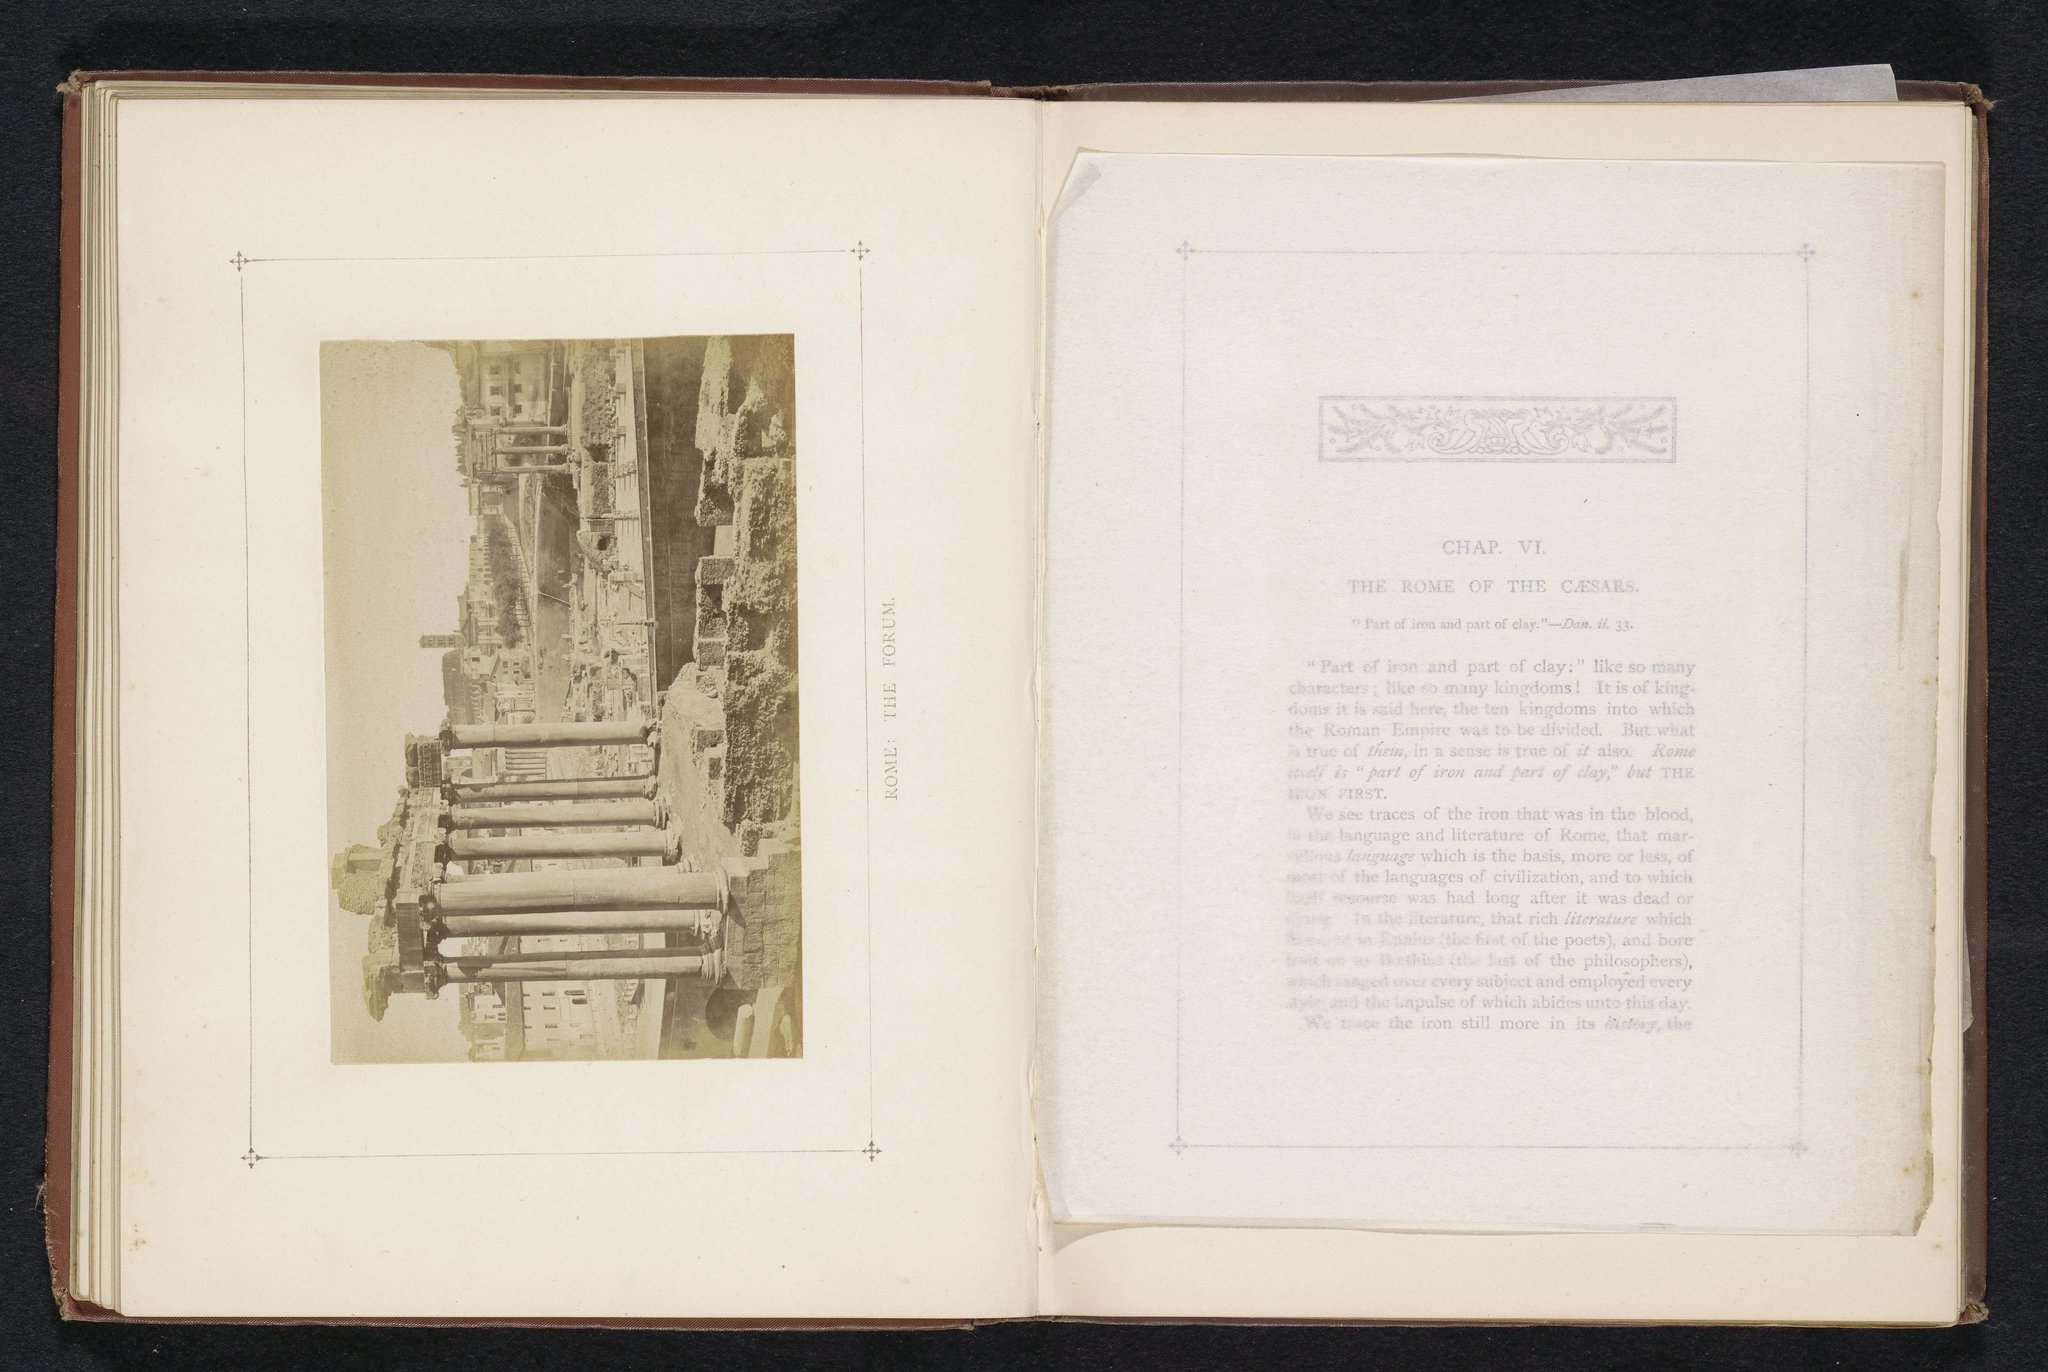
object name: photograph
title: Rome: the forum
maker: Anonymous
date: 1872-1882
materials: photographic support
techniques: albumen print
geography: forum romanum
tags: landscape with ruins